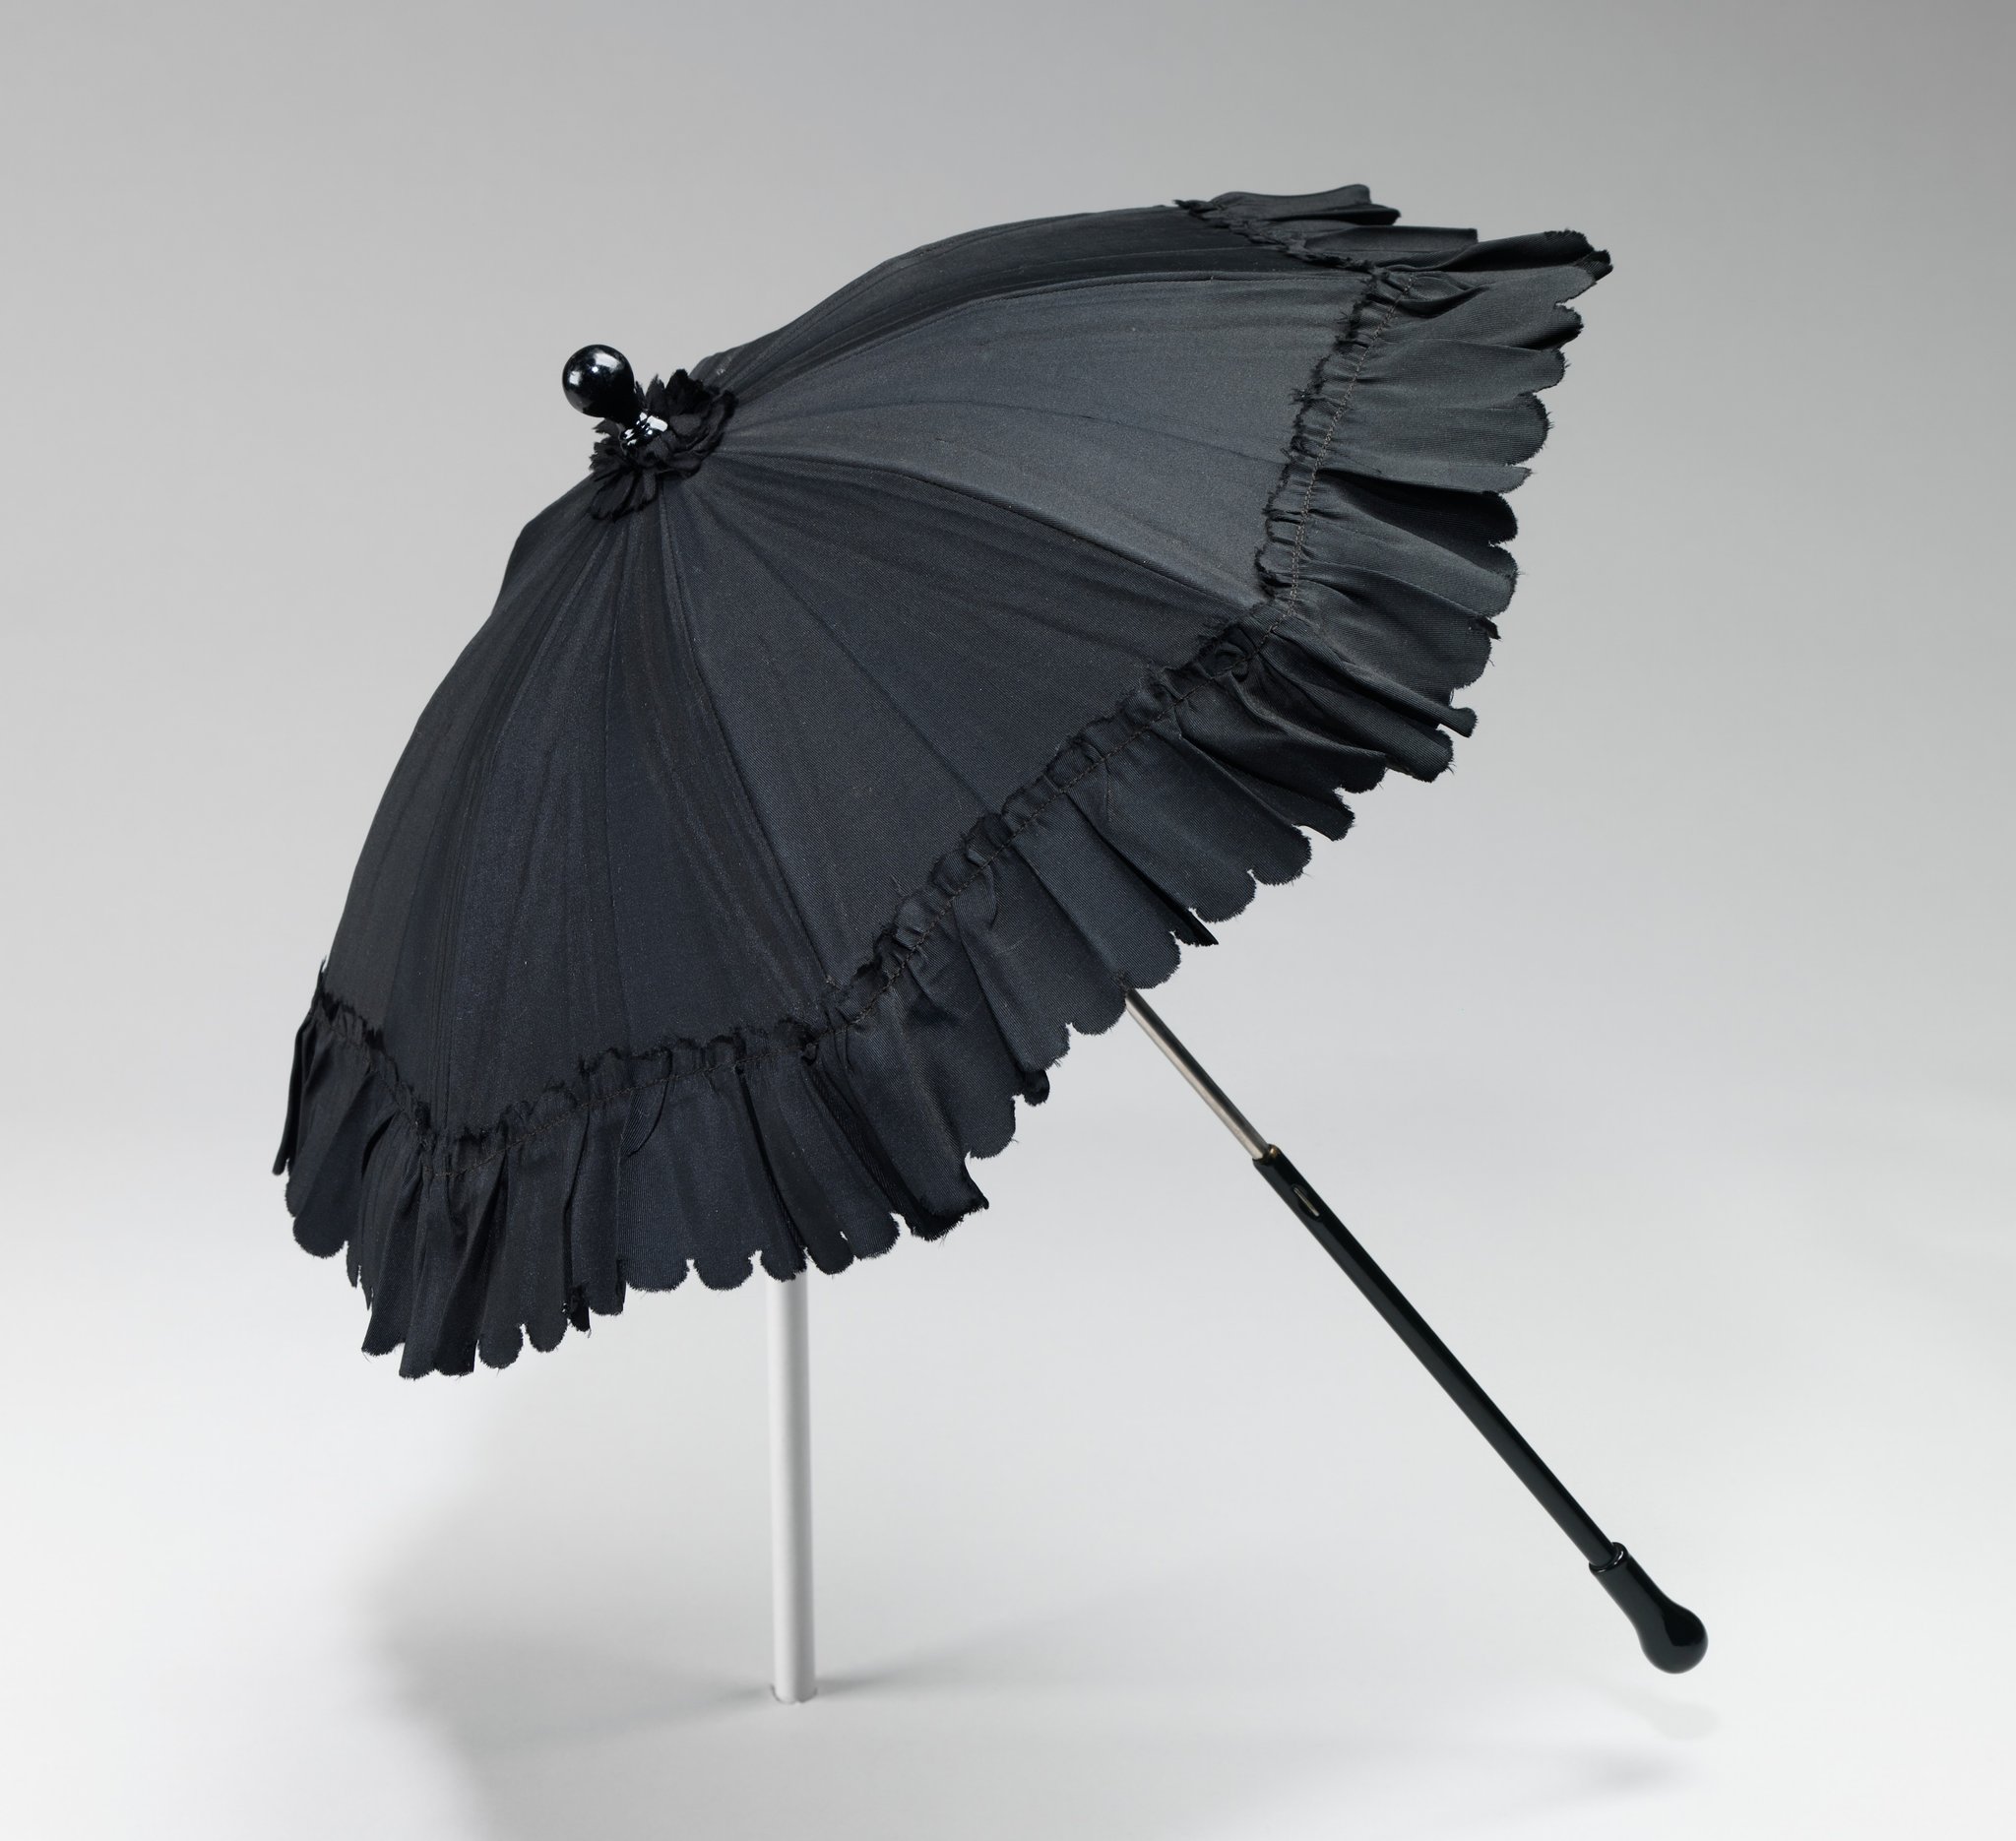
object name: parasol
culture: american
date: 1870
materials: metal, silk, wood